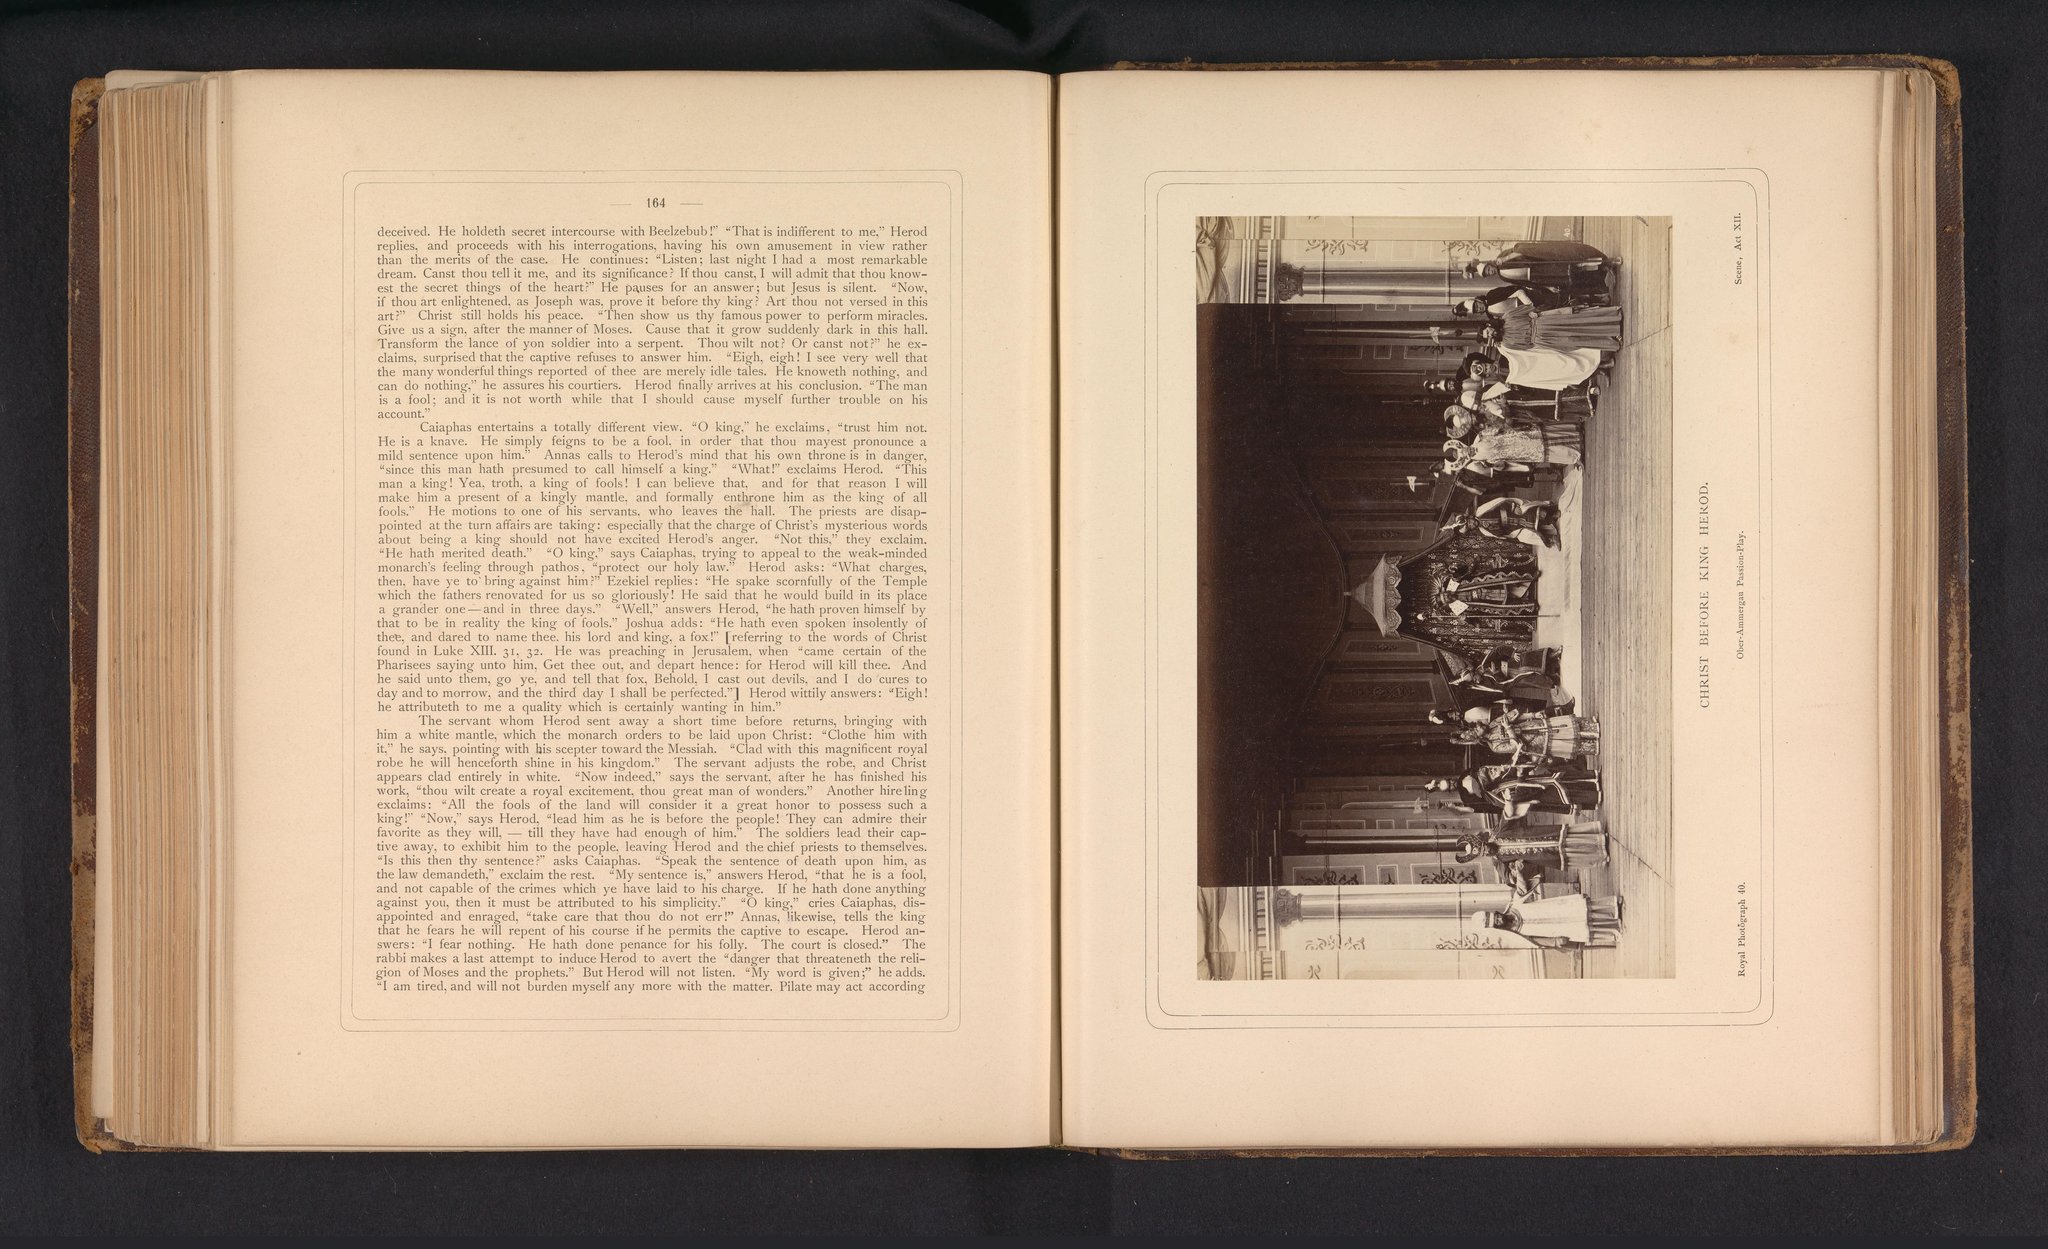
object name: photograph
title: Christ before king Herod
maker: joseph albert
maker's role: printer, publisher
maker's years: 1825-1886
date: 1868-1873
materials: photographic support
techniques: albumen print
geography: oberammergau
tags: group of actors, troupe; actors on the stage, christ before king herod; sometimes a gorgeous robe is brought (luke 23:8-11)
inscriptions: number: ‘Royal Photograph 40.’